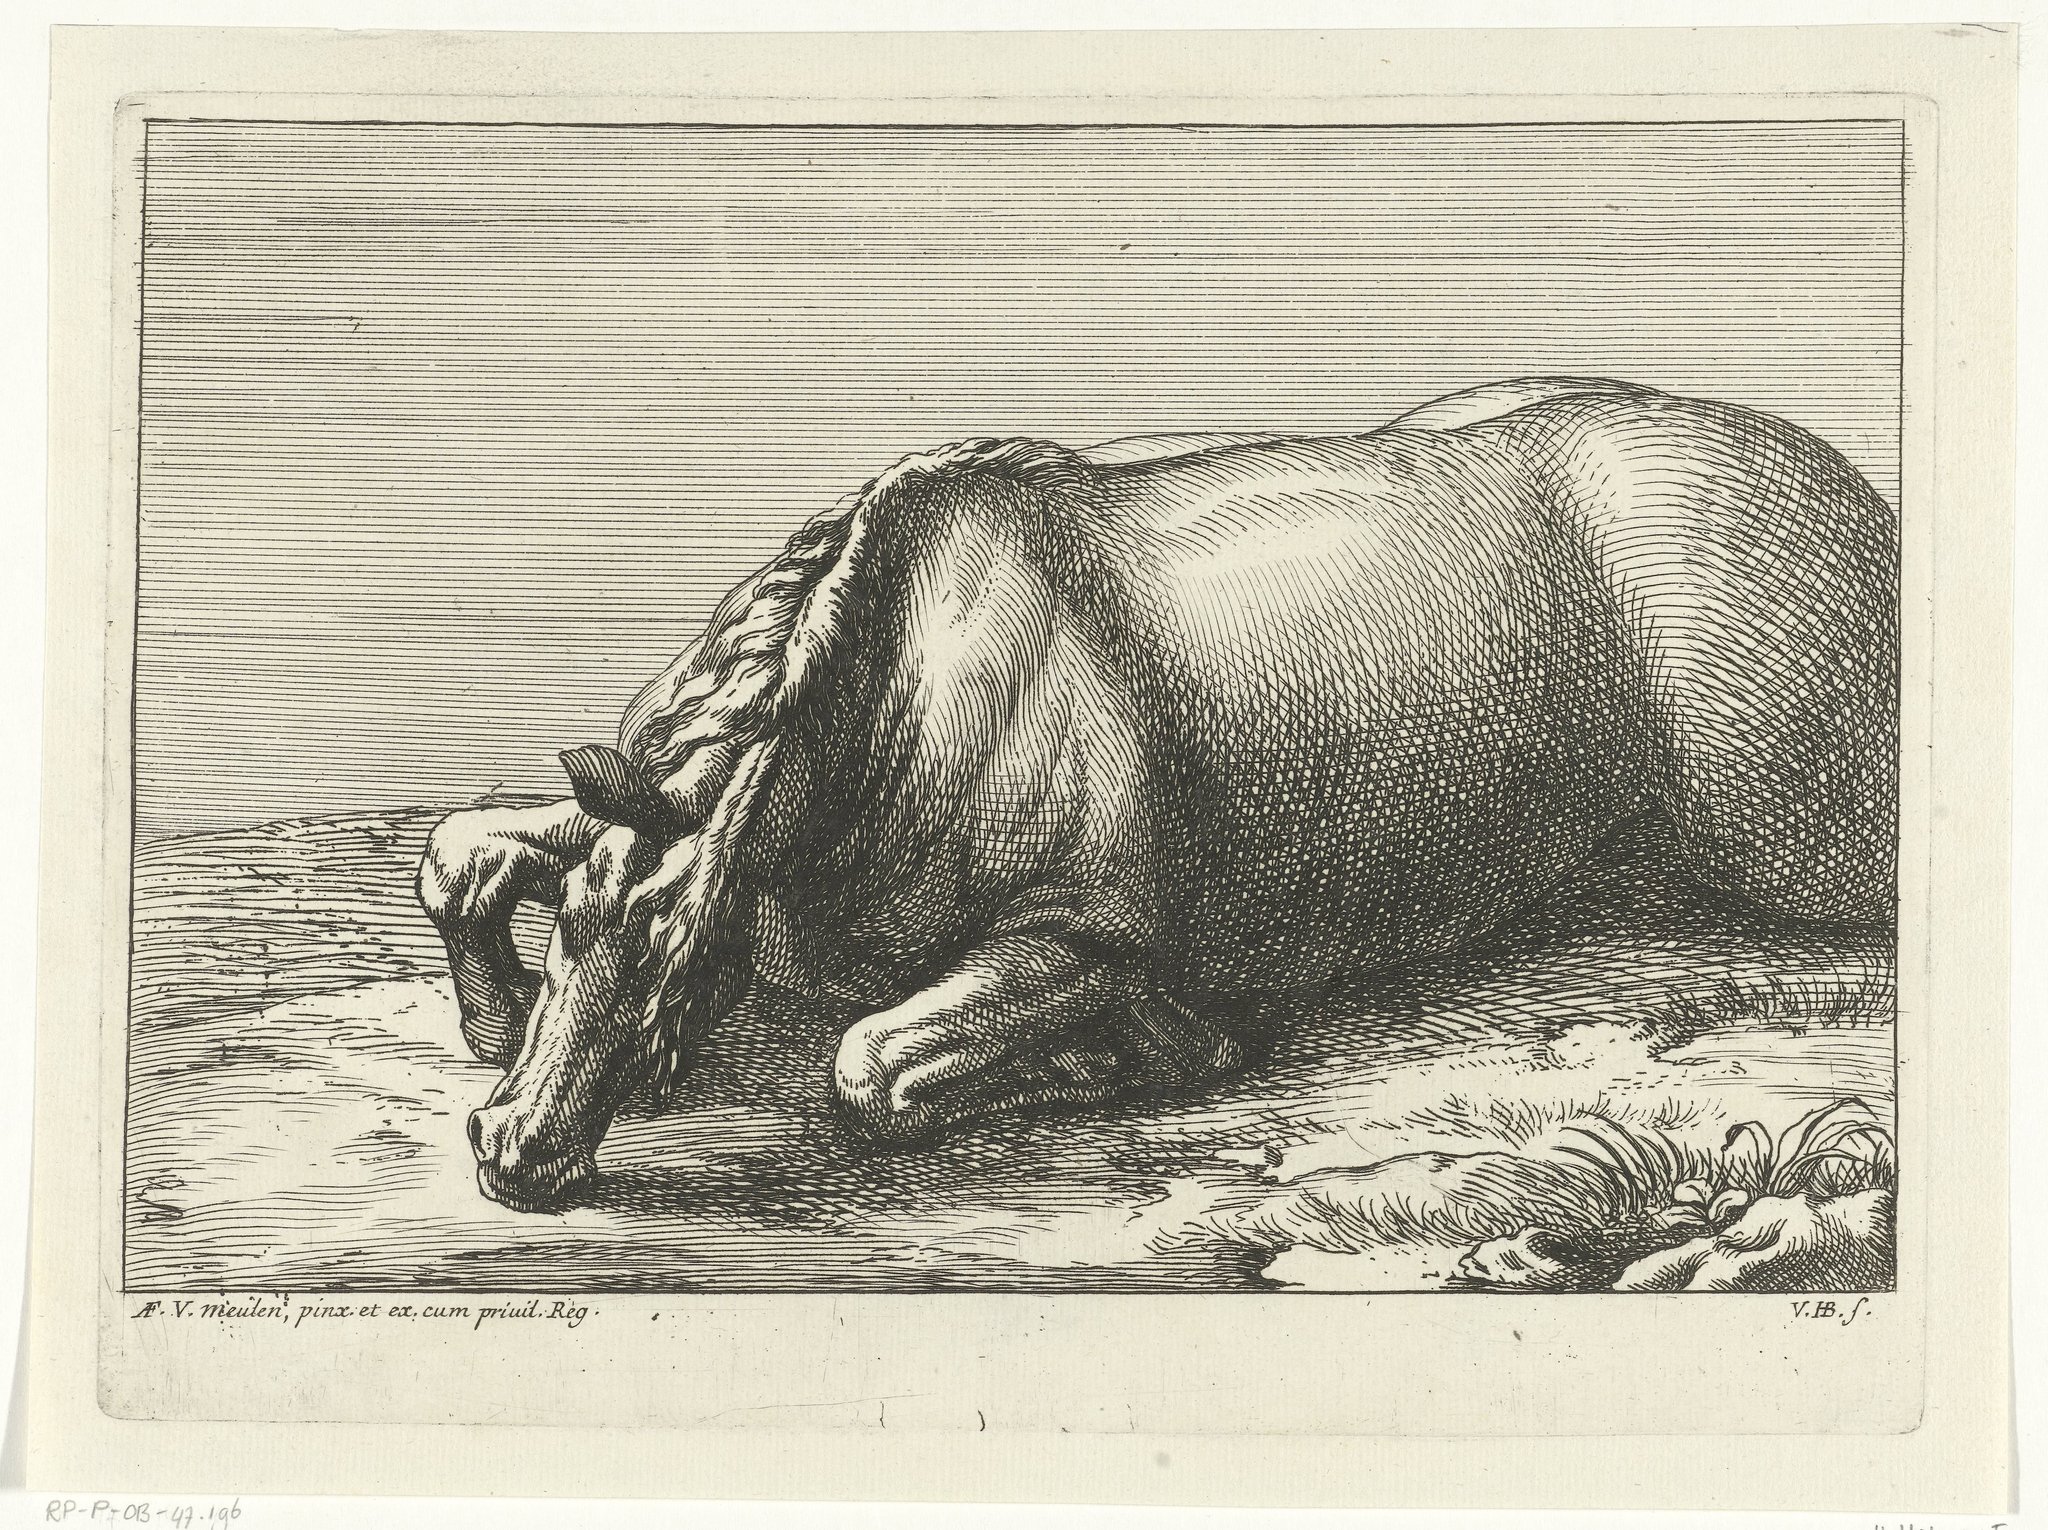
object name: print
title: Gesneuveld paard op de linkerzij gezien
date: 1674-1733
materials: paper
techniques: engraving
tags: horse (+ dying animal; death of animal; dead animal)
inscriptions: collector's mark: Lugt 2228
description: Op de buik liggend paard op de linkerzij gezien.